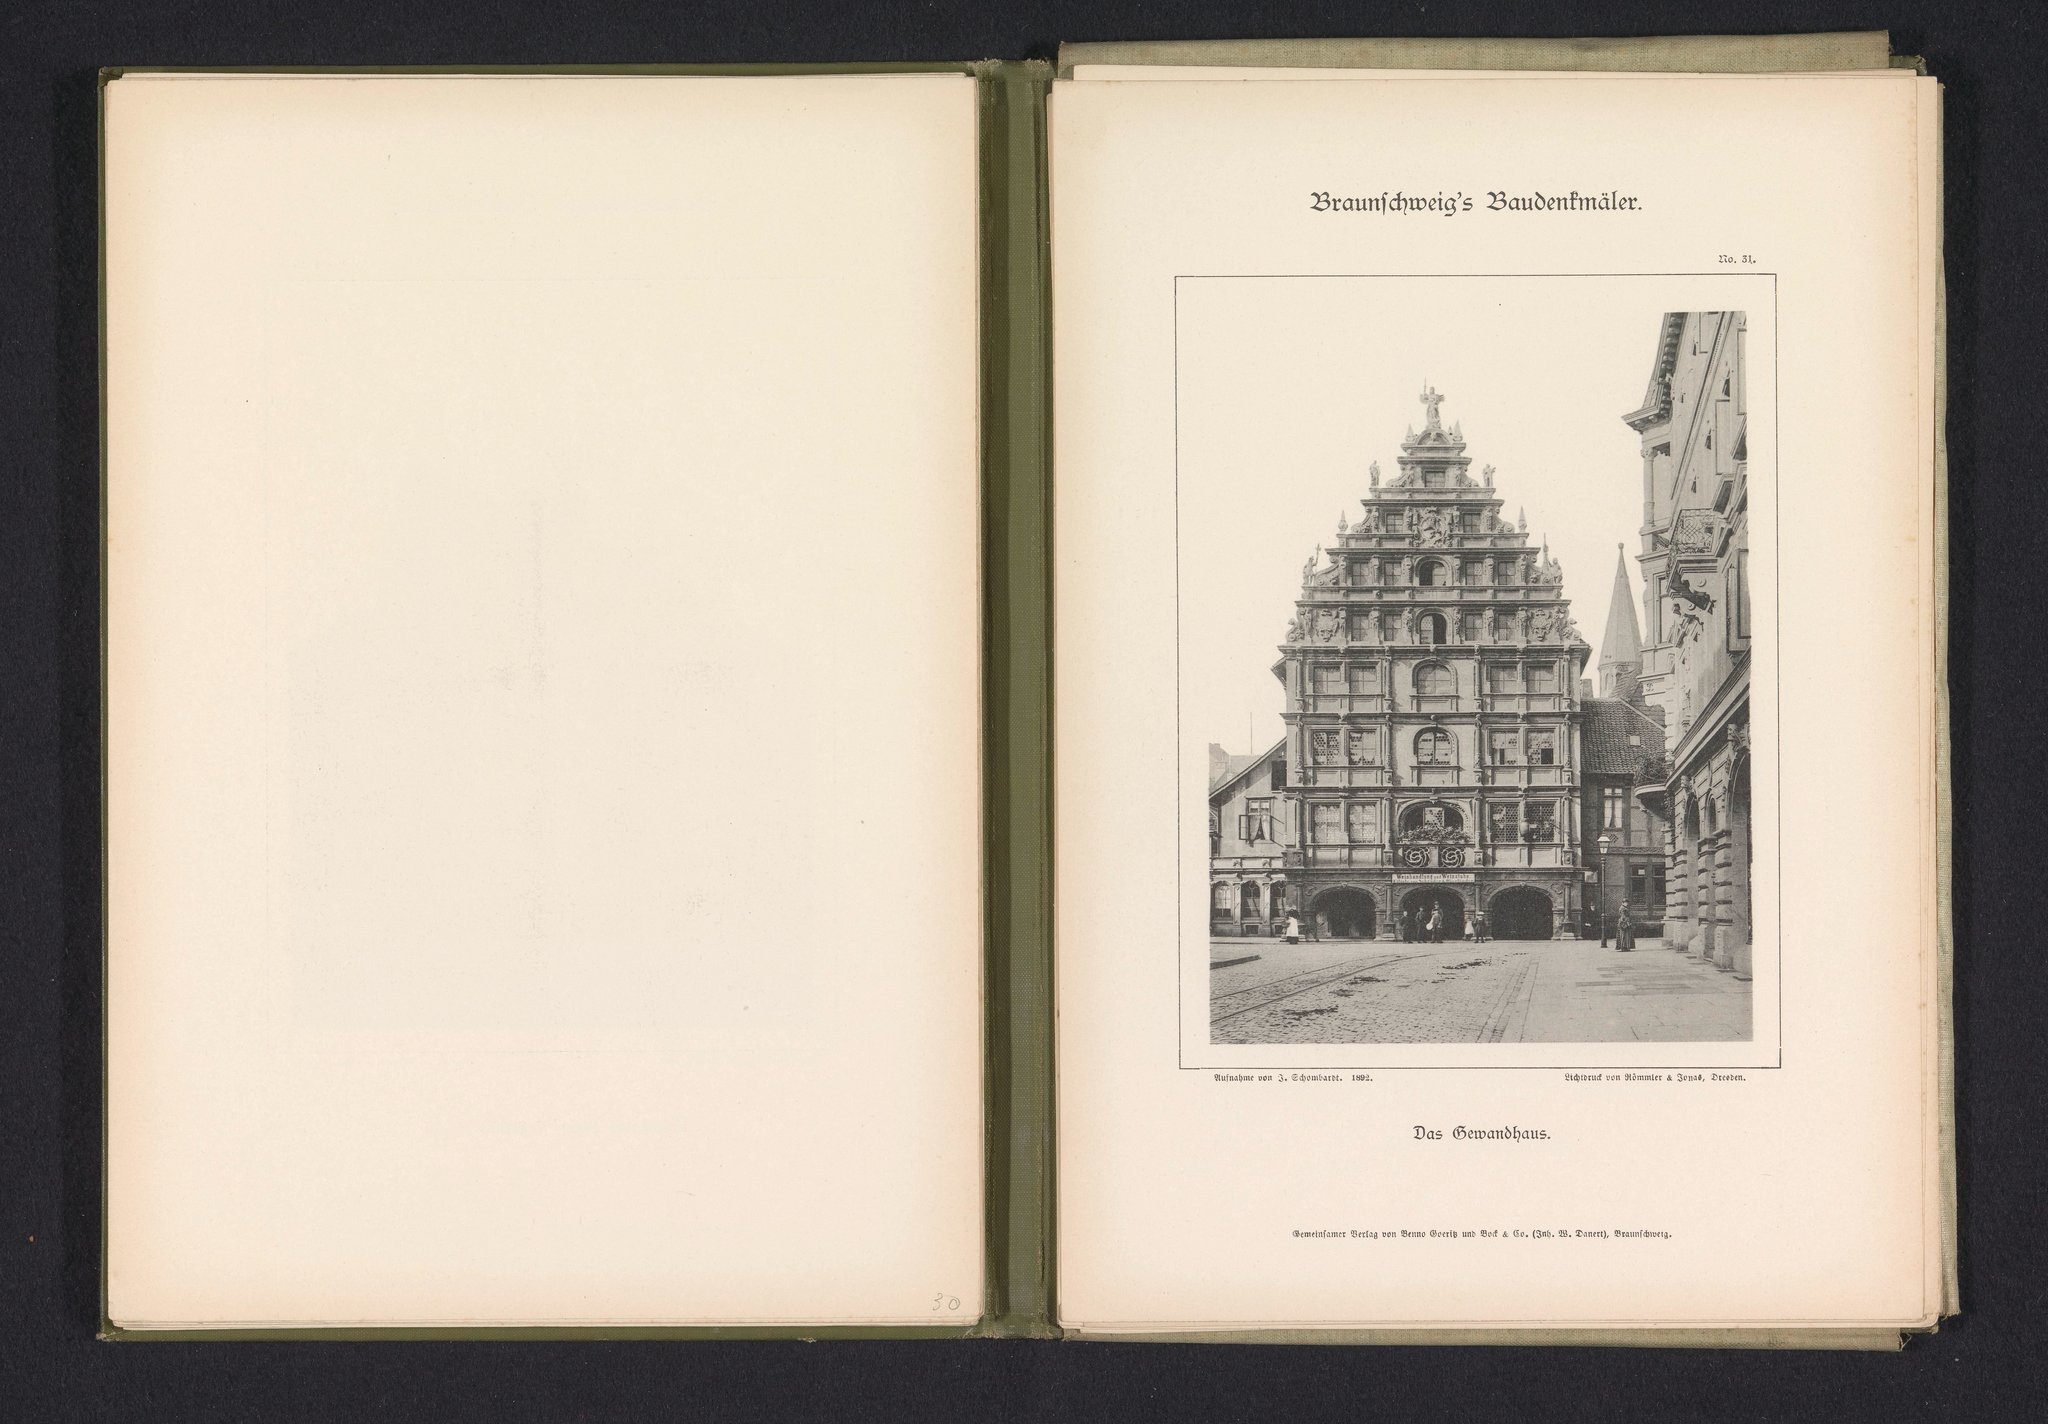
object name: page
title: Braunschweig's Baudenkmäler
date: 1892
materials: paper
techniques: photograph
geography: braunschweig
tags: guildhall, façade (of house or building)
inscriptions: number: ‘No. 31.’